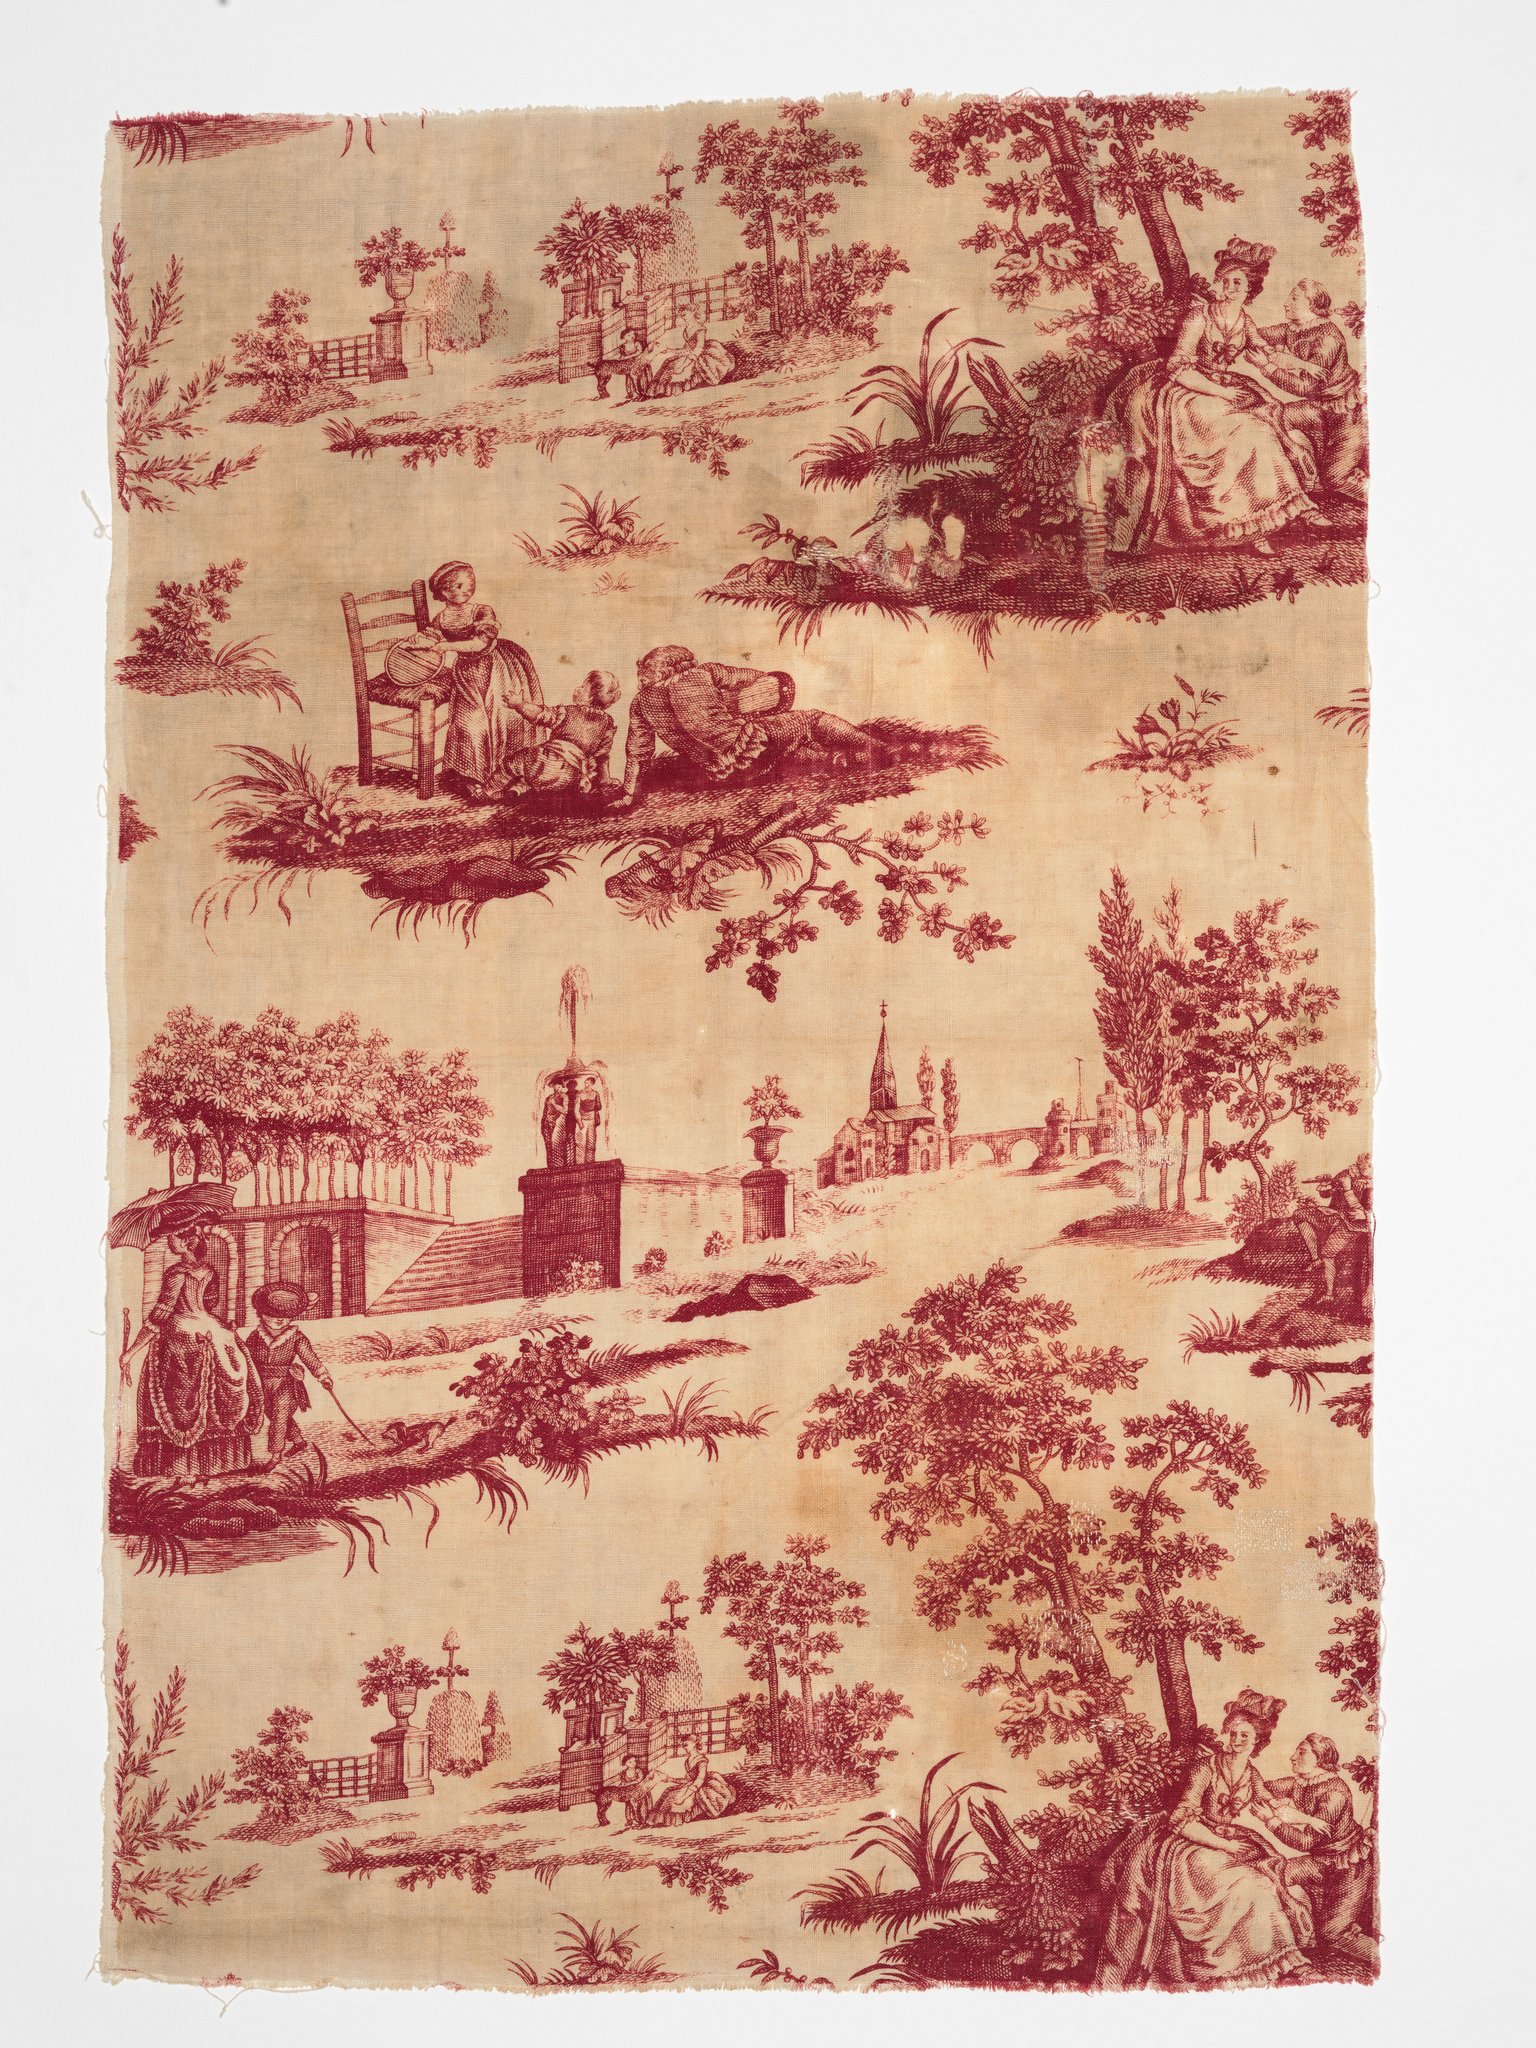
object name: piece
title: "Les Tuileries"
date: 1701-1800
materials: cotton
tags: children,men,women